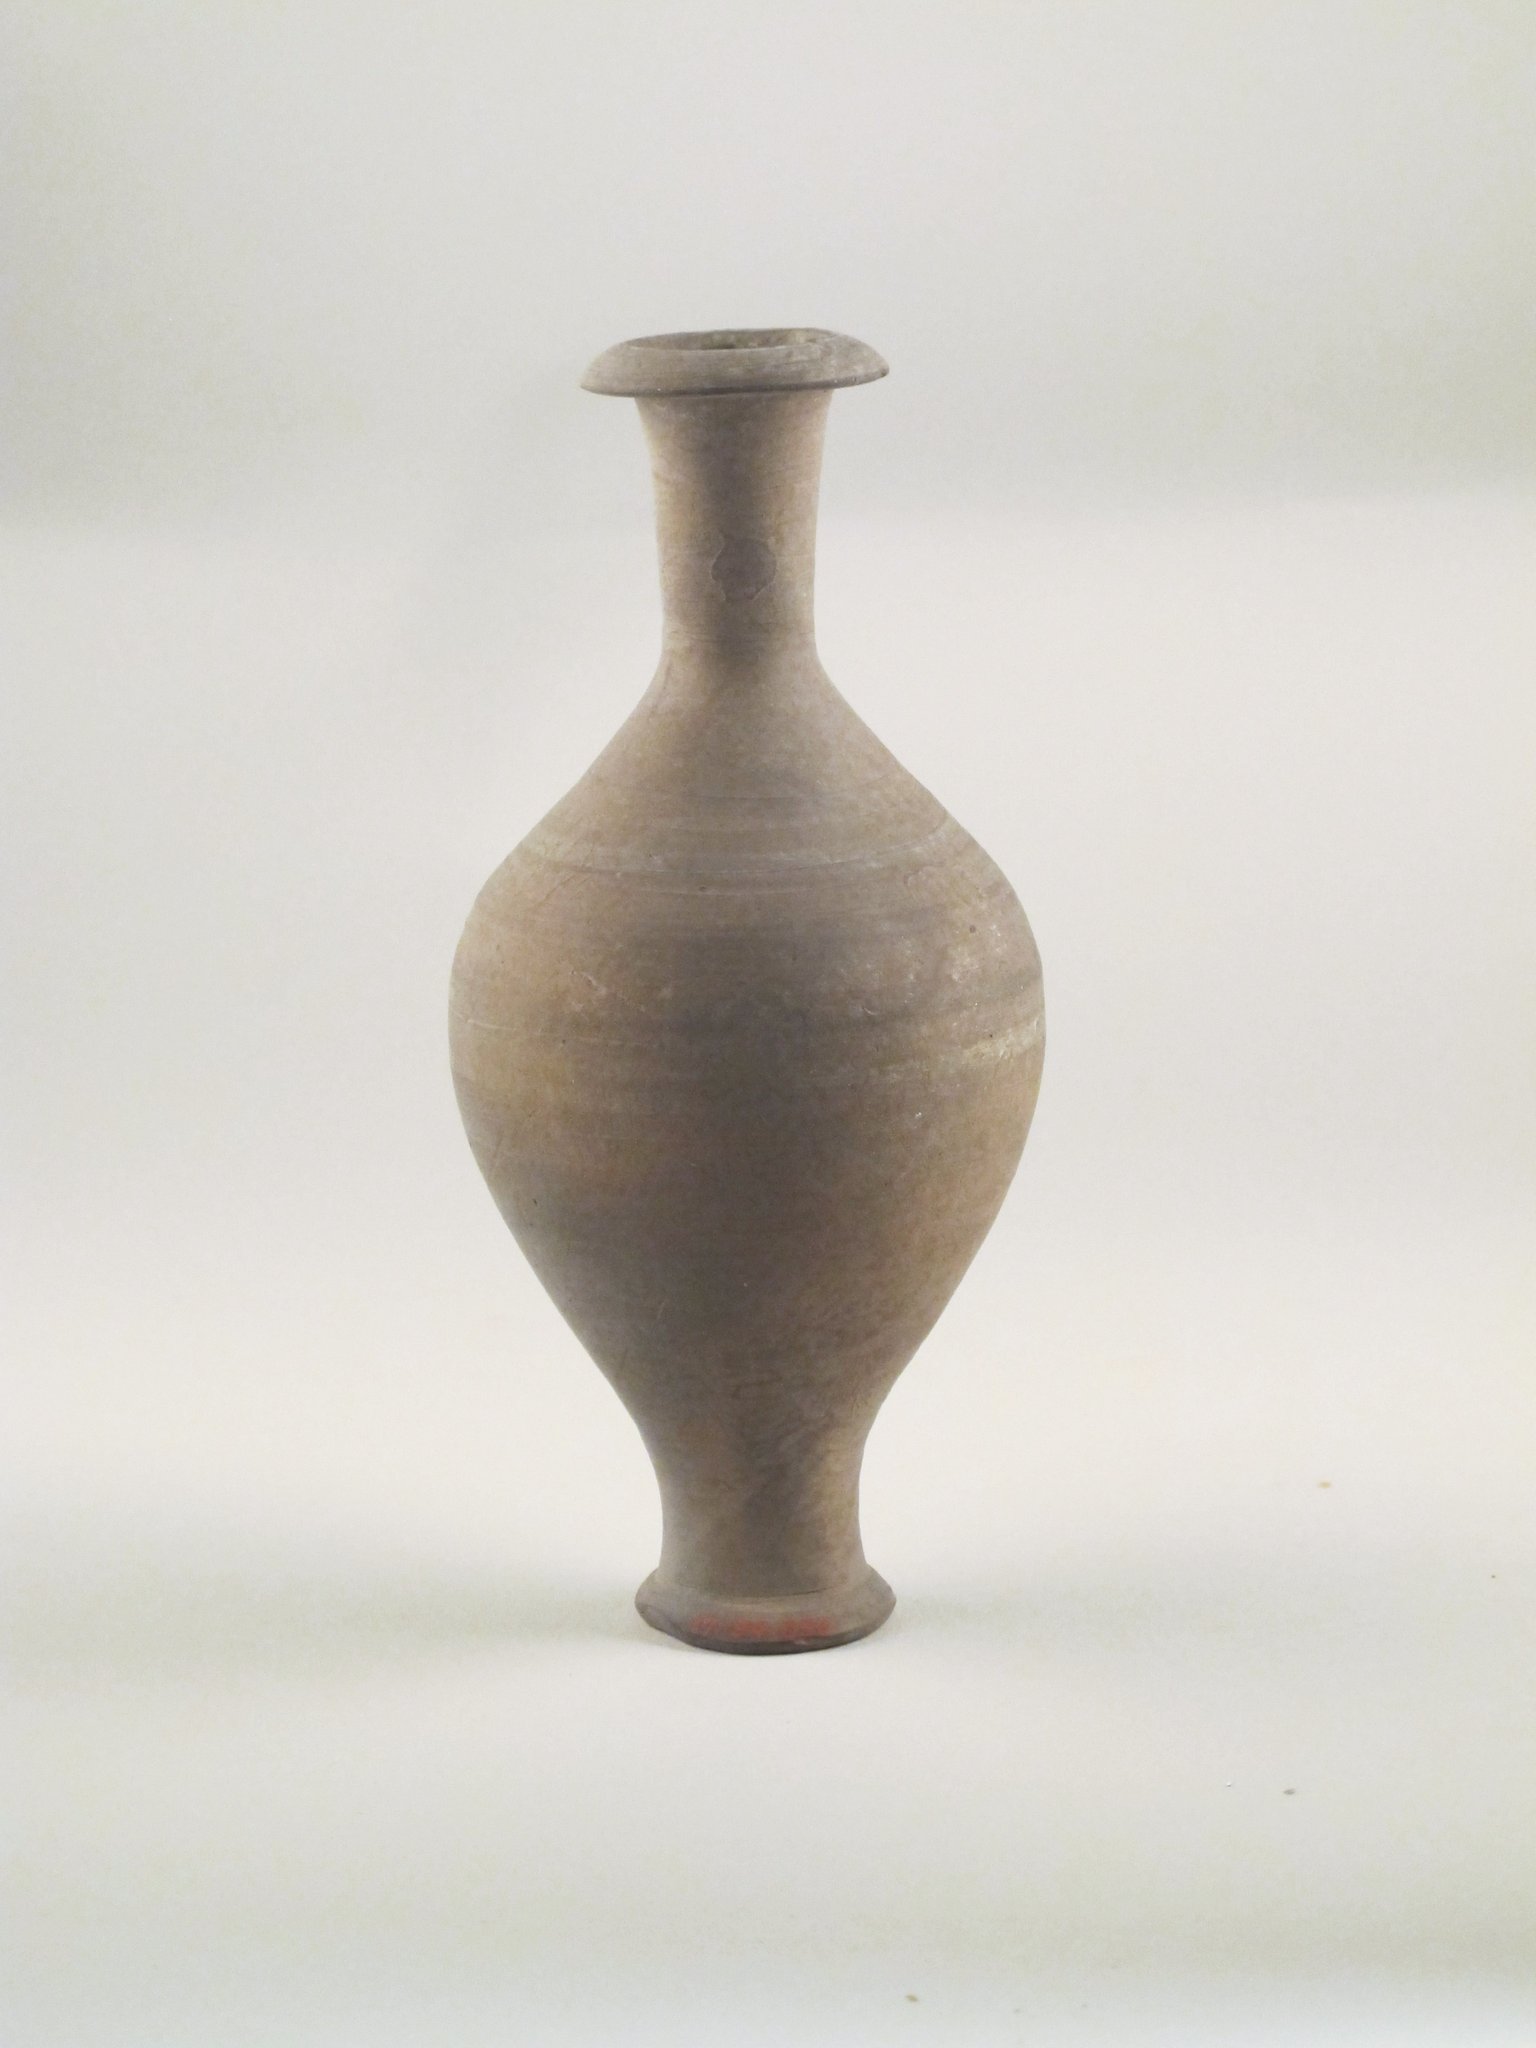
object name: vase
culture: roman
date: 670 BCE-330 CE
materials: terracotta